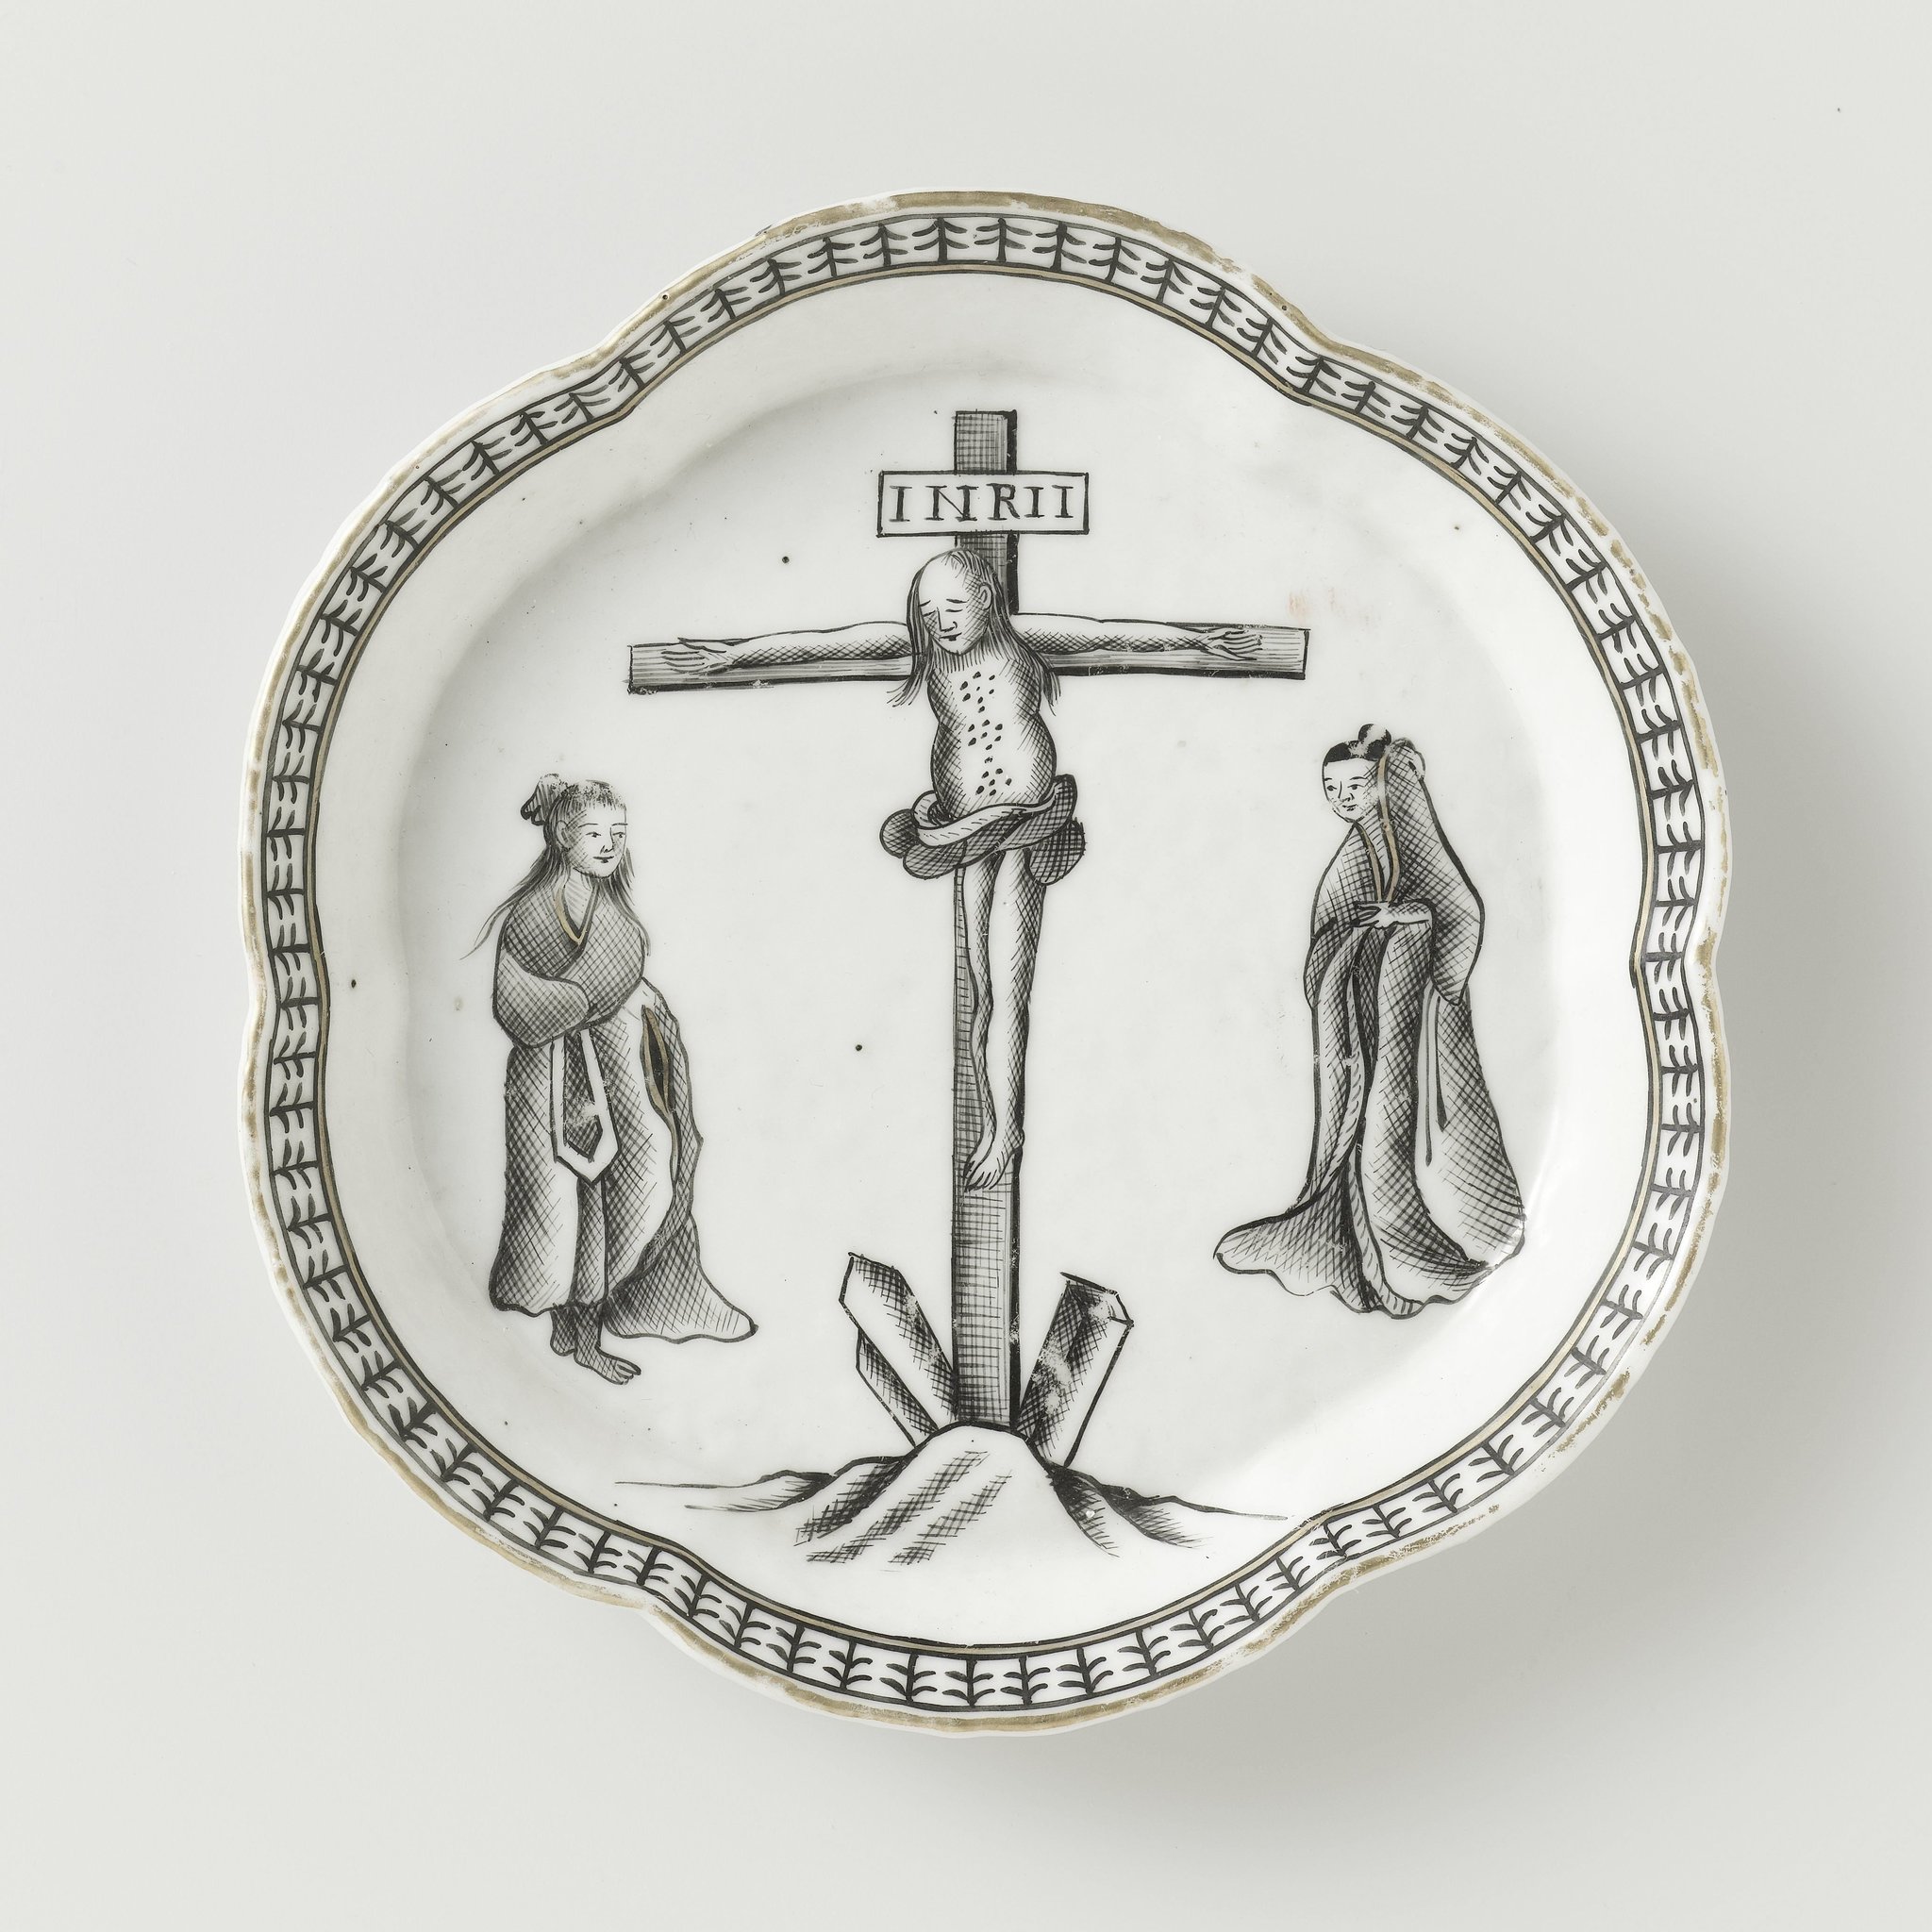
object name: pattipan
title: Teapot stand with a crucifixion scene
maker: Anonymous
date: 1780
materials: glaze, gold, paint, porcelain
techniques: firing, gilding, turning, vitrification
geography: china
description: Pattipan van porselein met zeslobbige wand, beschilderd op het glazuur in zwart en goud. Op het plat een voorstelling van de Kruisiging met de twee Maria's; op de binnenrand een band met een decoratief patroon. Onderzijde ongeglazuurd. Onderdeel van een theeservies. Europese voorstelling in encre de Chine.